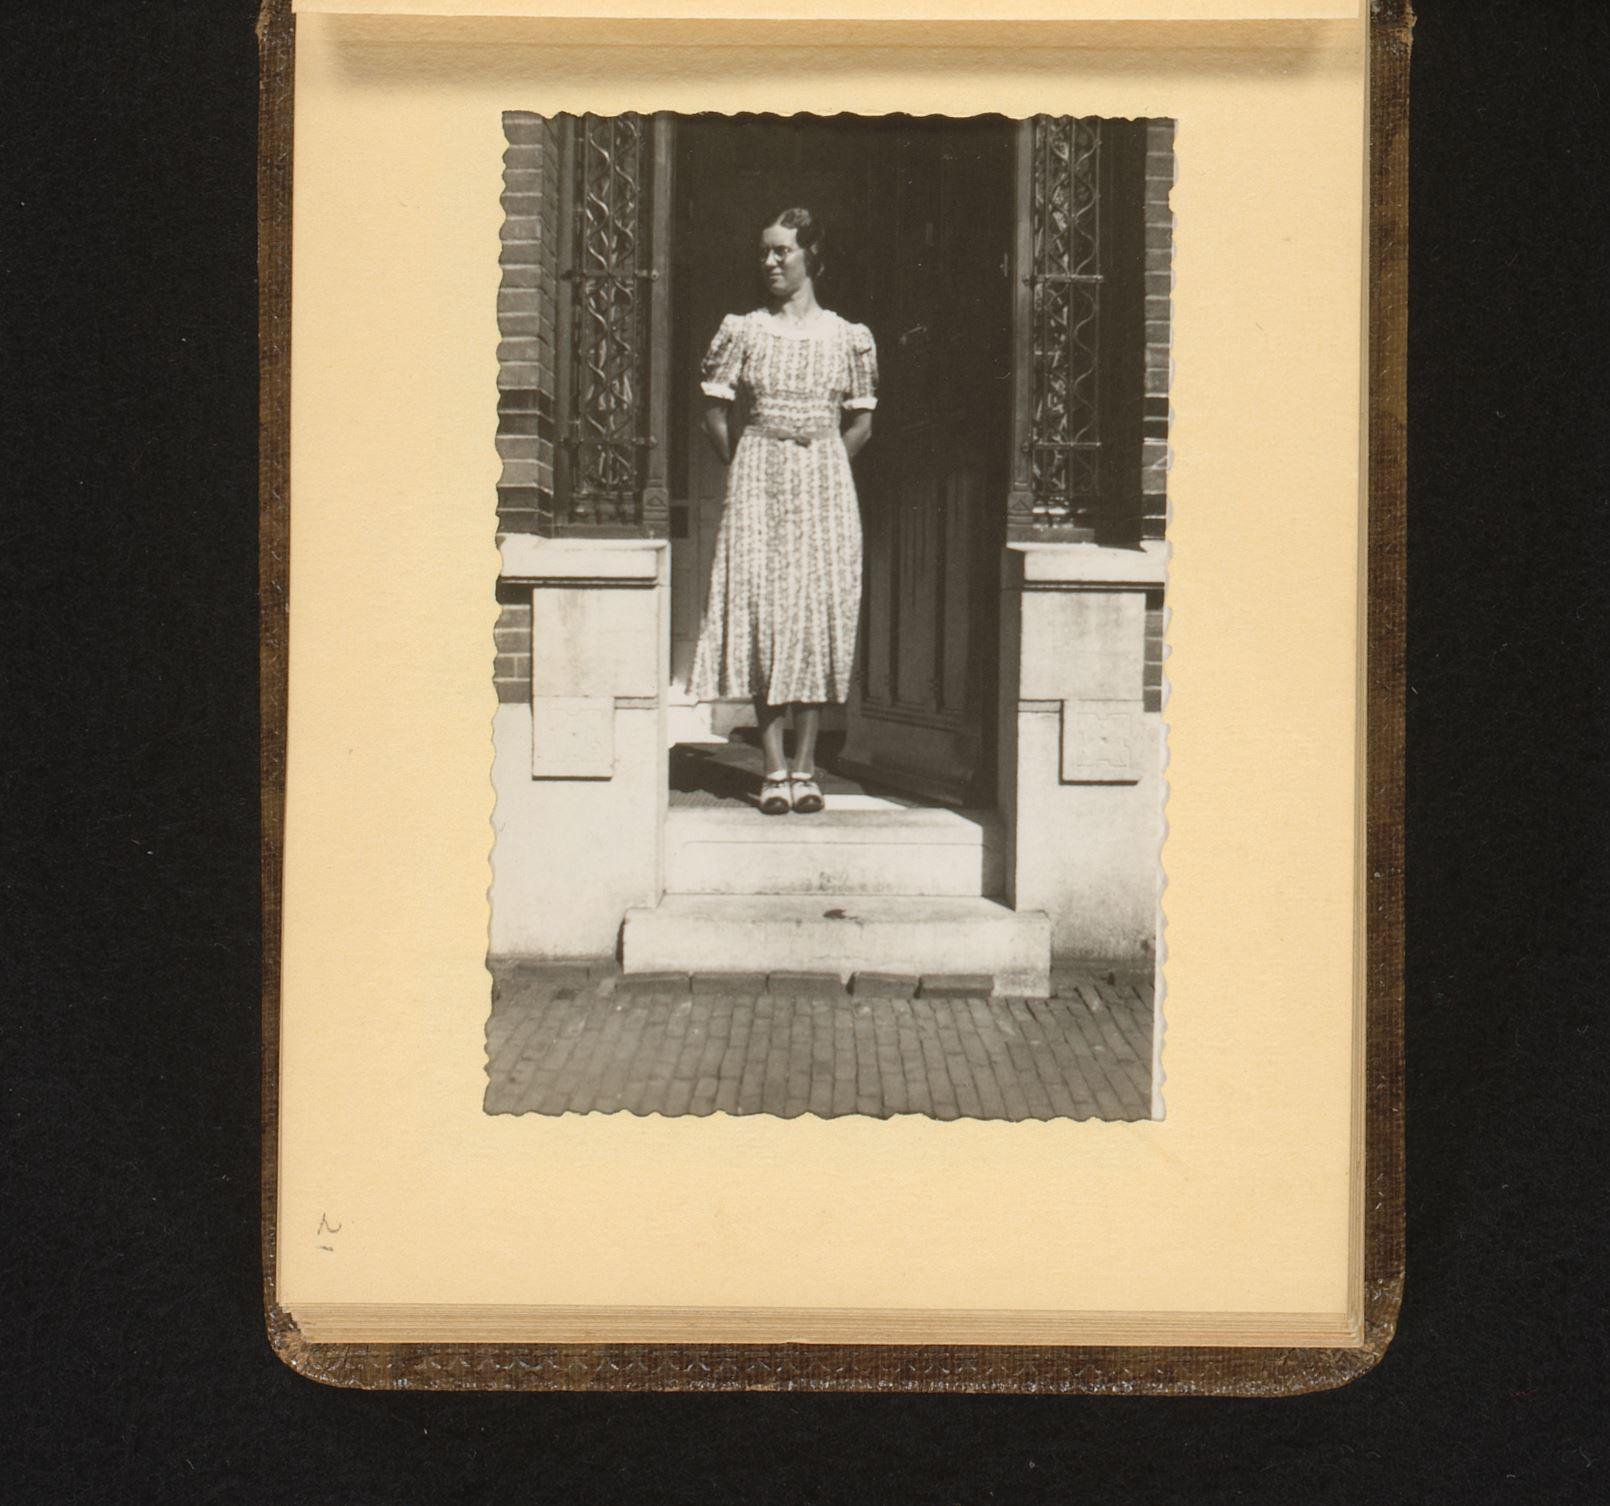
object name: photograph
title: Vrouw in deur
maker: Anonymous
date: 1938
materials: cardboard, photographic support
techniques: gelatin silver print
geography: rotterdam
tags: door, family life at home, rotterdam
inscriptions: inscription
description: Albumblad met een foto van een vrouw staande in de deuropening. Onderdeel van het familiealbum 1938-1939.